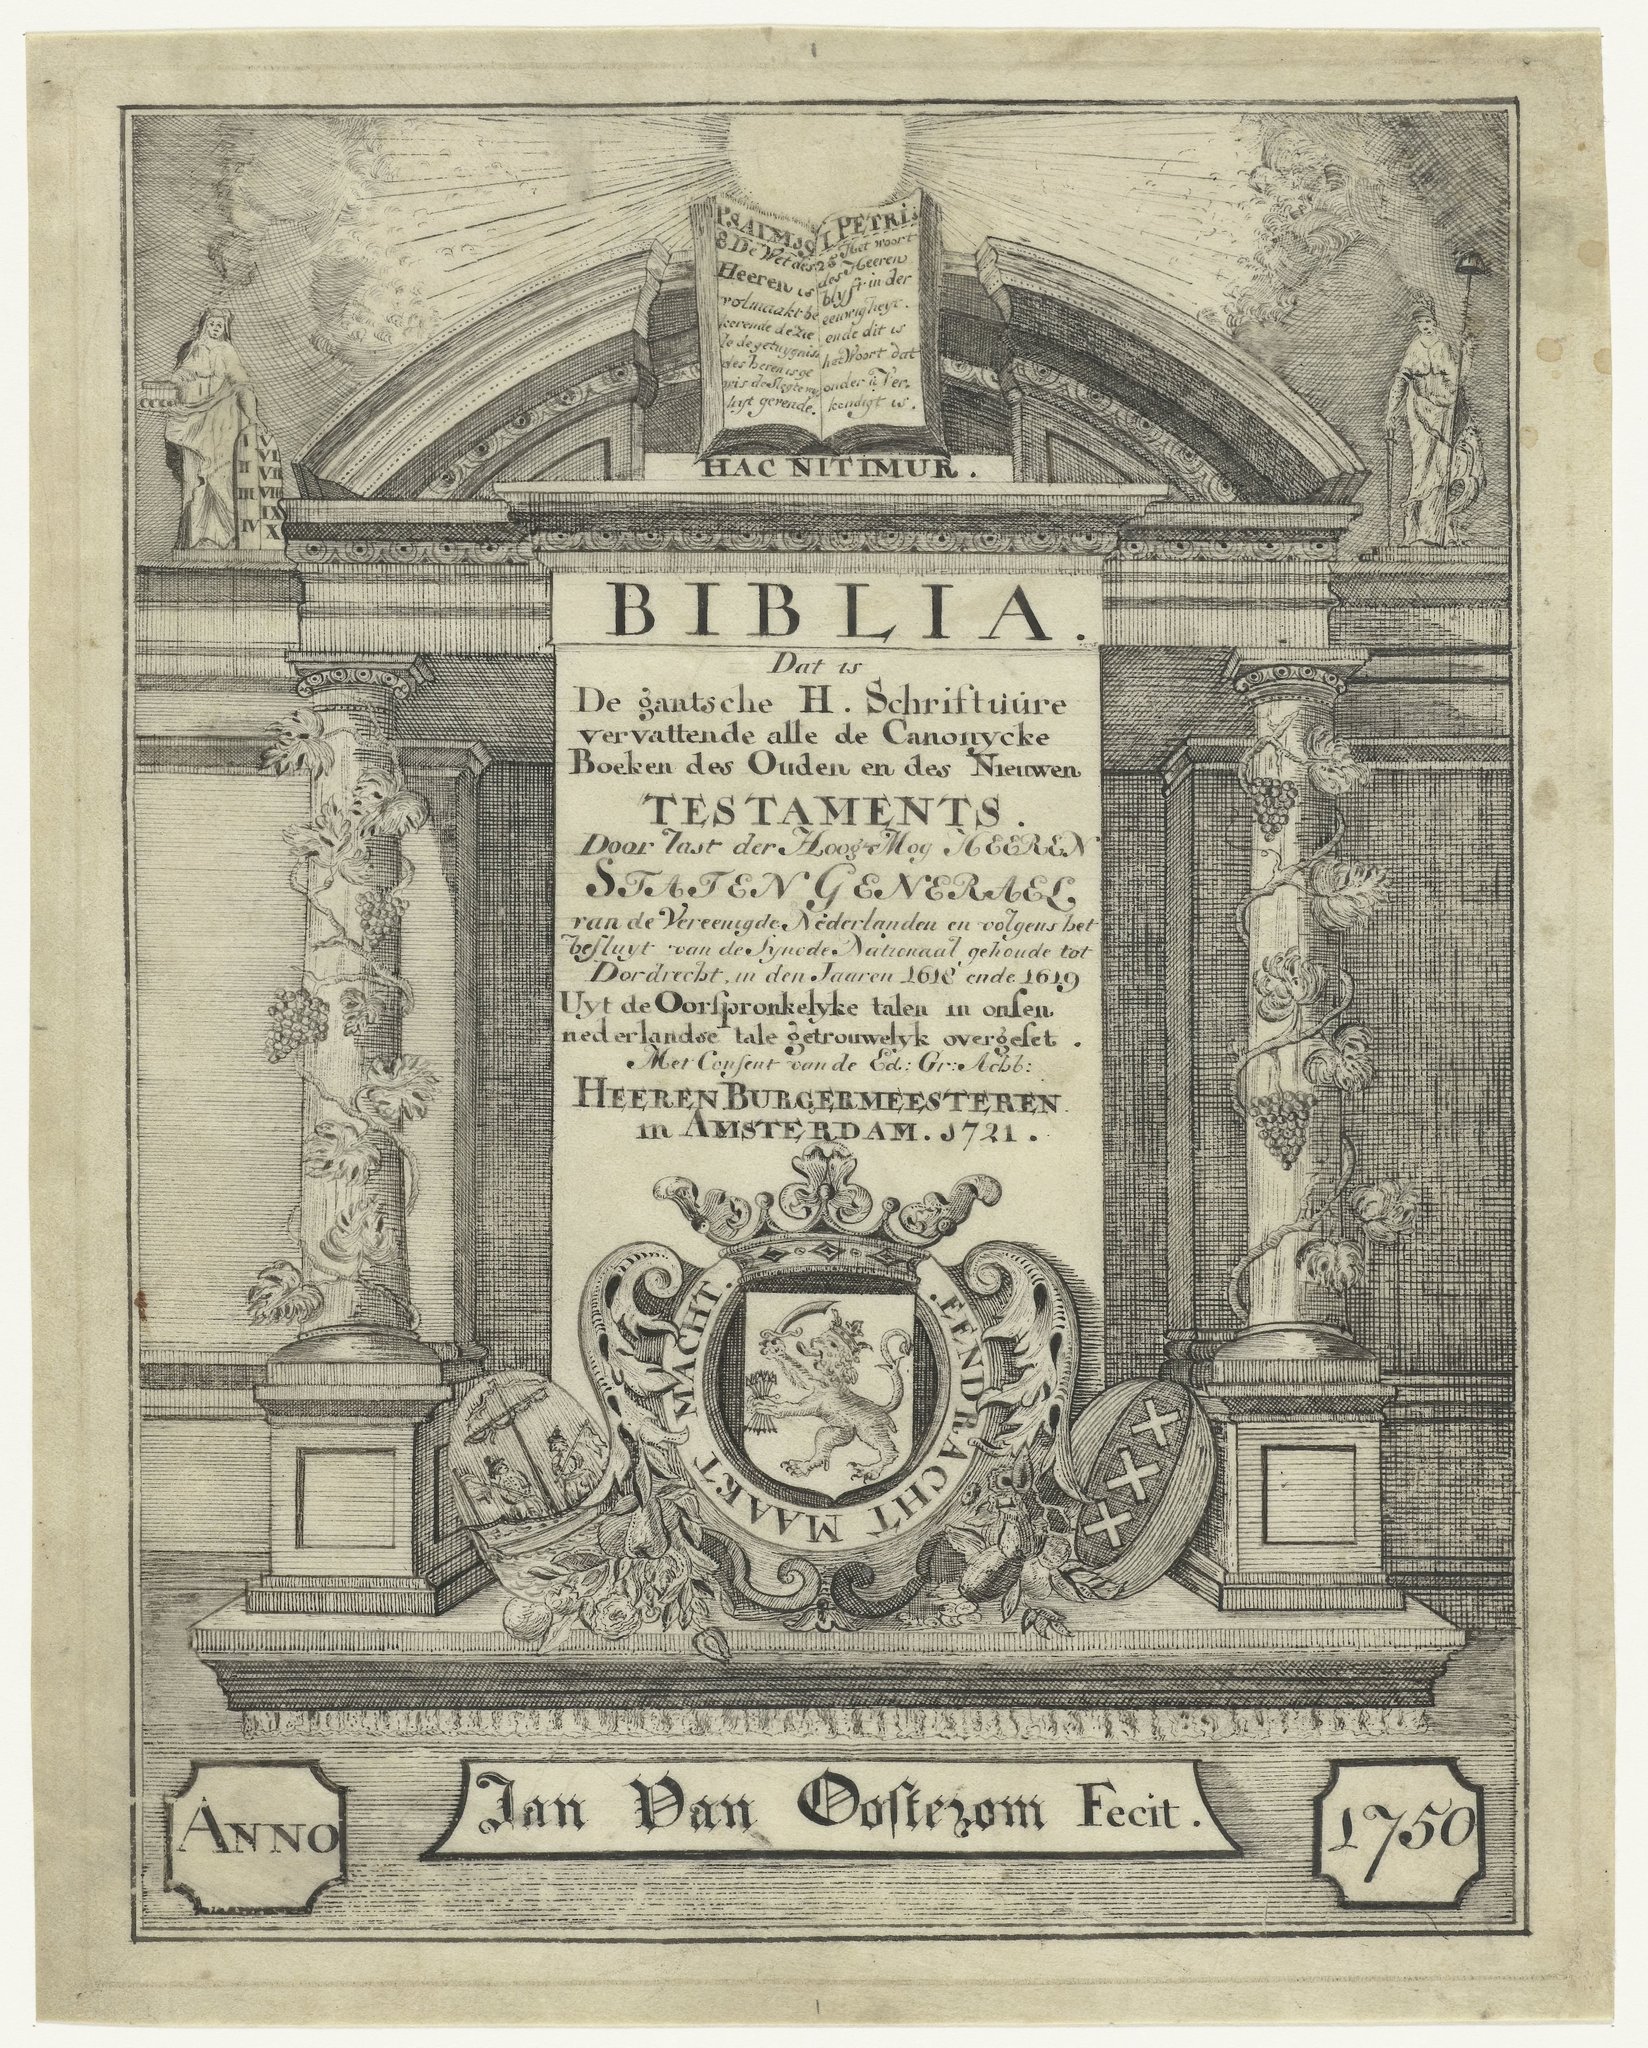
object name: drawing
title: Titelblad van een bijbel uit 1721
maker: jan van oosterom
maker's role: draughtsman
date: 1750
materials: ink, parchment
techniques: pen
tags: frontispiece, print, e.g.: engraving, etching, lithograph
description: Natekening naar het titelblad van een bijbel uit 1721.